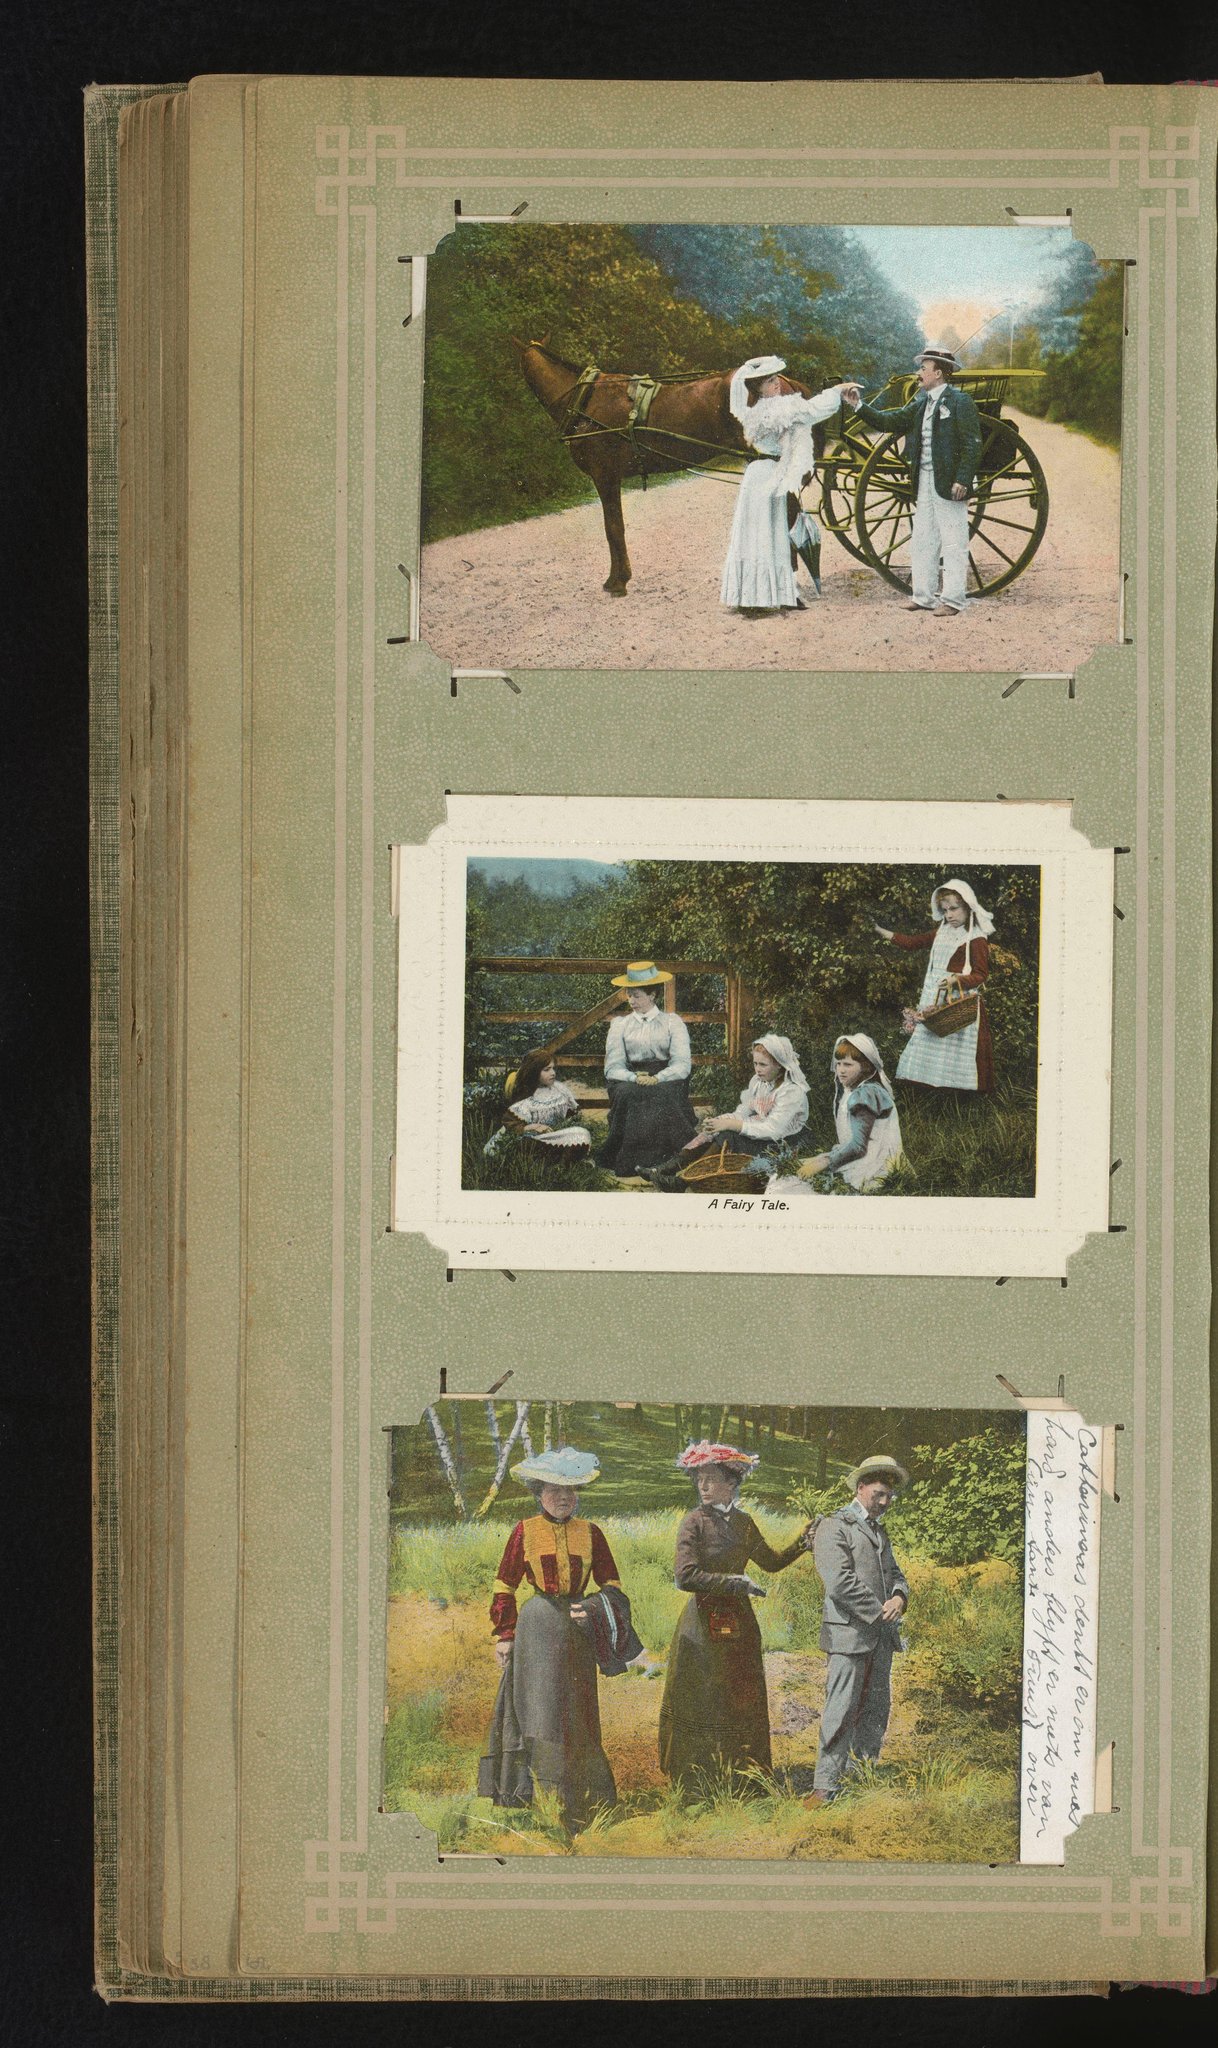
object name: album leaf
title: Echtpaar voor een koets, een moeder en haar vier dochters tijdens een picknick en twee vrouwen en een man tijdens een wandeling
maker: Anonymous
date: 1900-1930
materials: cardboard, ink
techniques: chromolithography, pen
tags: adult woman, girl (child between toddler and youth) (+ four persons), adult man, two-wheeled vehicle drawn by one animal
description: Deze prenten maken deel uit van een album.